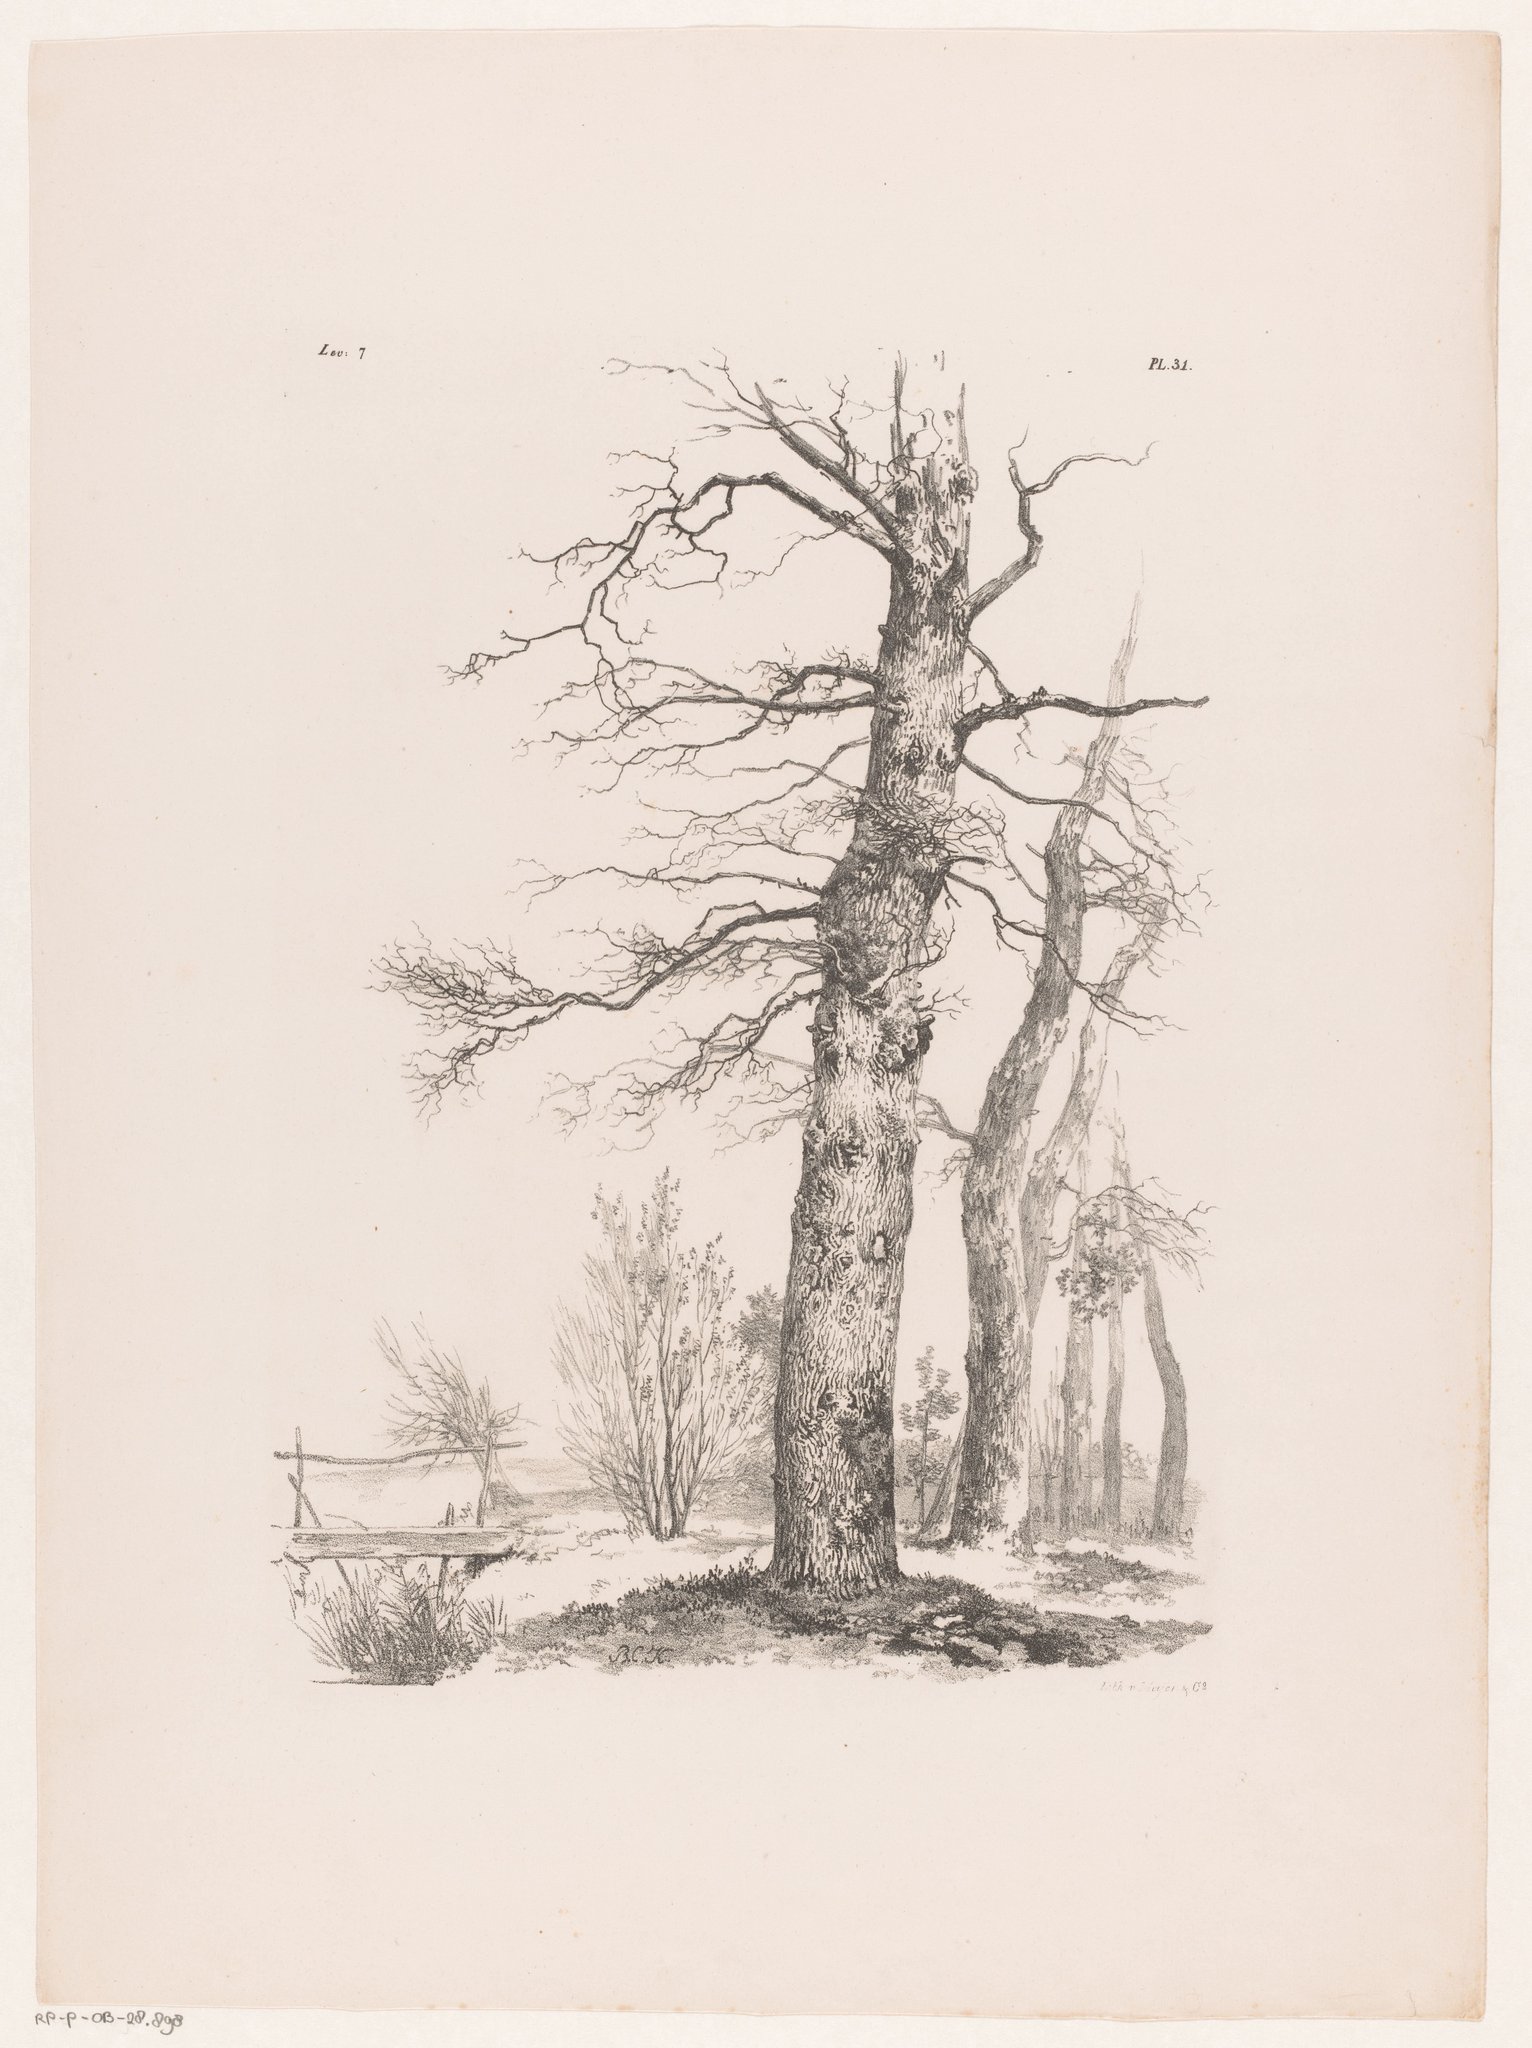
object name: print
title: Bomen en brug in landschap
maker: barend cornelis koekkoek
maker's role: draughtsman, painter, print maker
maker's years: 1803-1862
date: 1844-1845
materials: paper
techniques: lithograph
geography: amsterdam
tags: shrubs, groups of trees, bridge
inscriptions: collector's mark: Lugt 2228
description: In 1829 en 1830 gaf Koekkoek, samen met Daiwaille, zes cahiers uit met ieder zes prenten getiteld Landschapstudiën. Deze werden gebruikt in het tekenonderwijs. Vijftien jaar later werd deze reeks, in een andere samenstelling nogmaals uitgegeven door Meyer en Comp in Amsterdam. Zie: De Bruyn Kops, 1963 en Nollert, 1997.